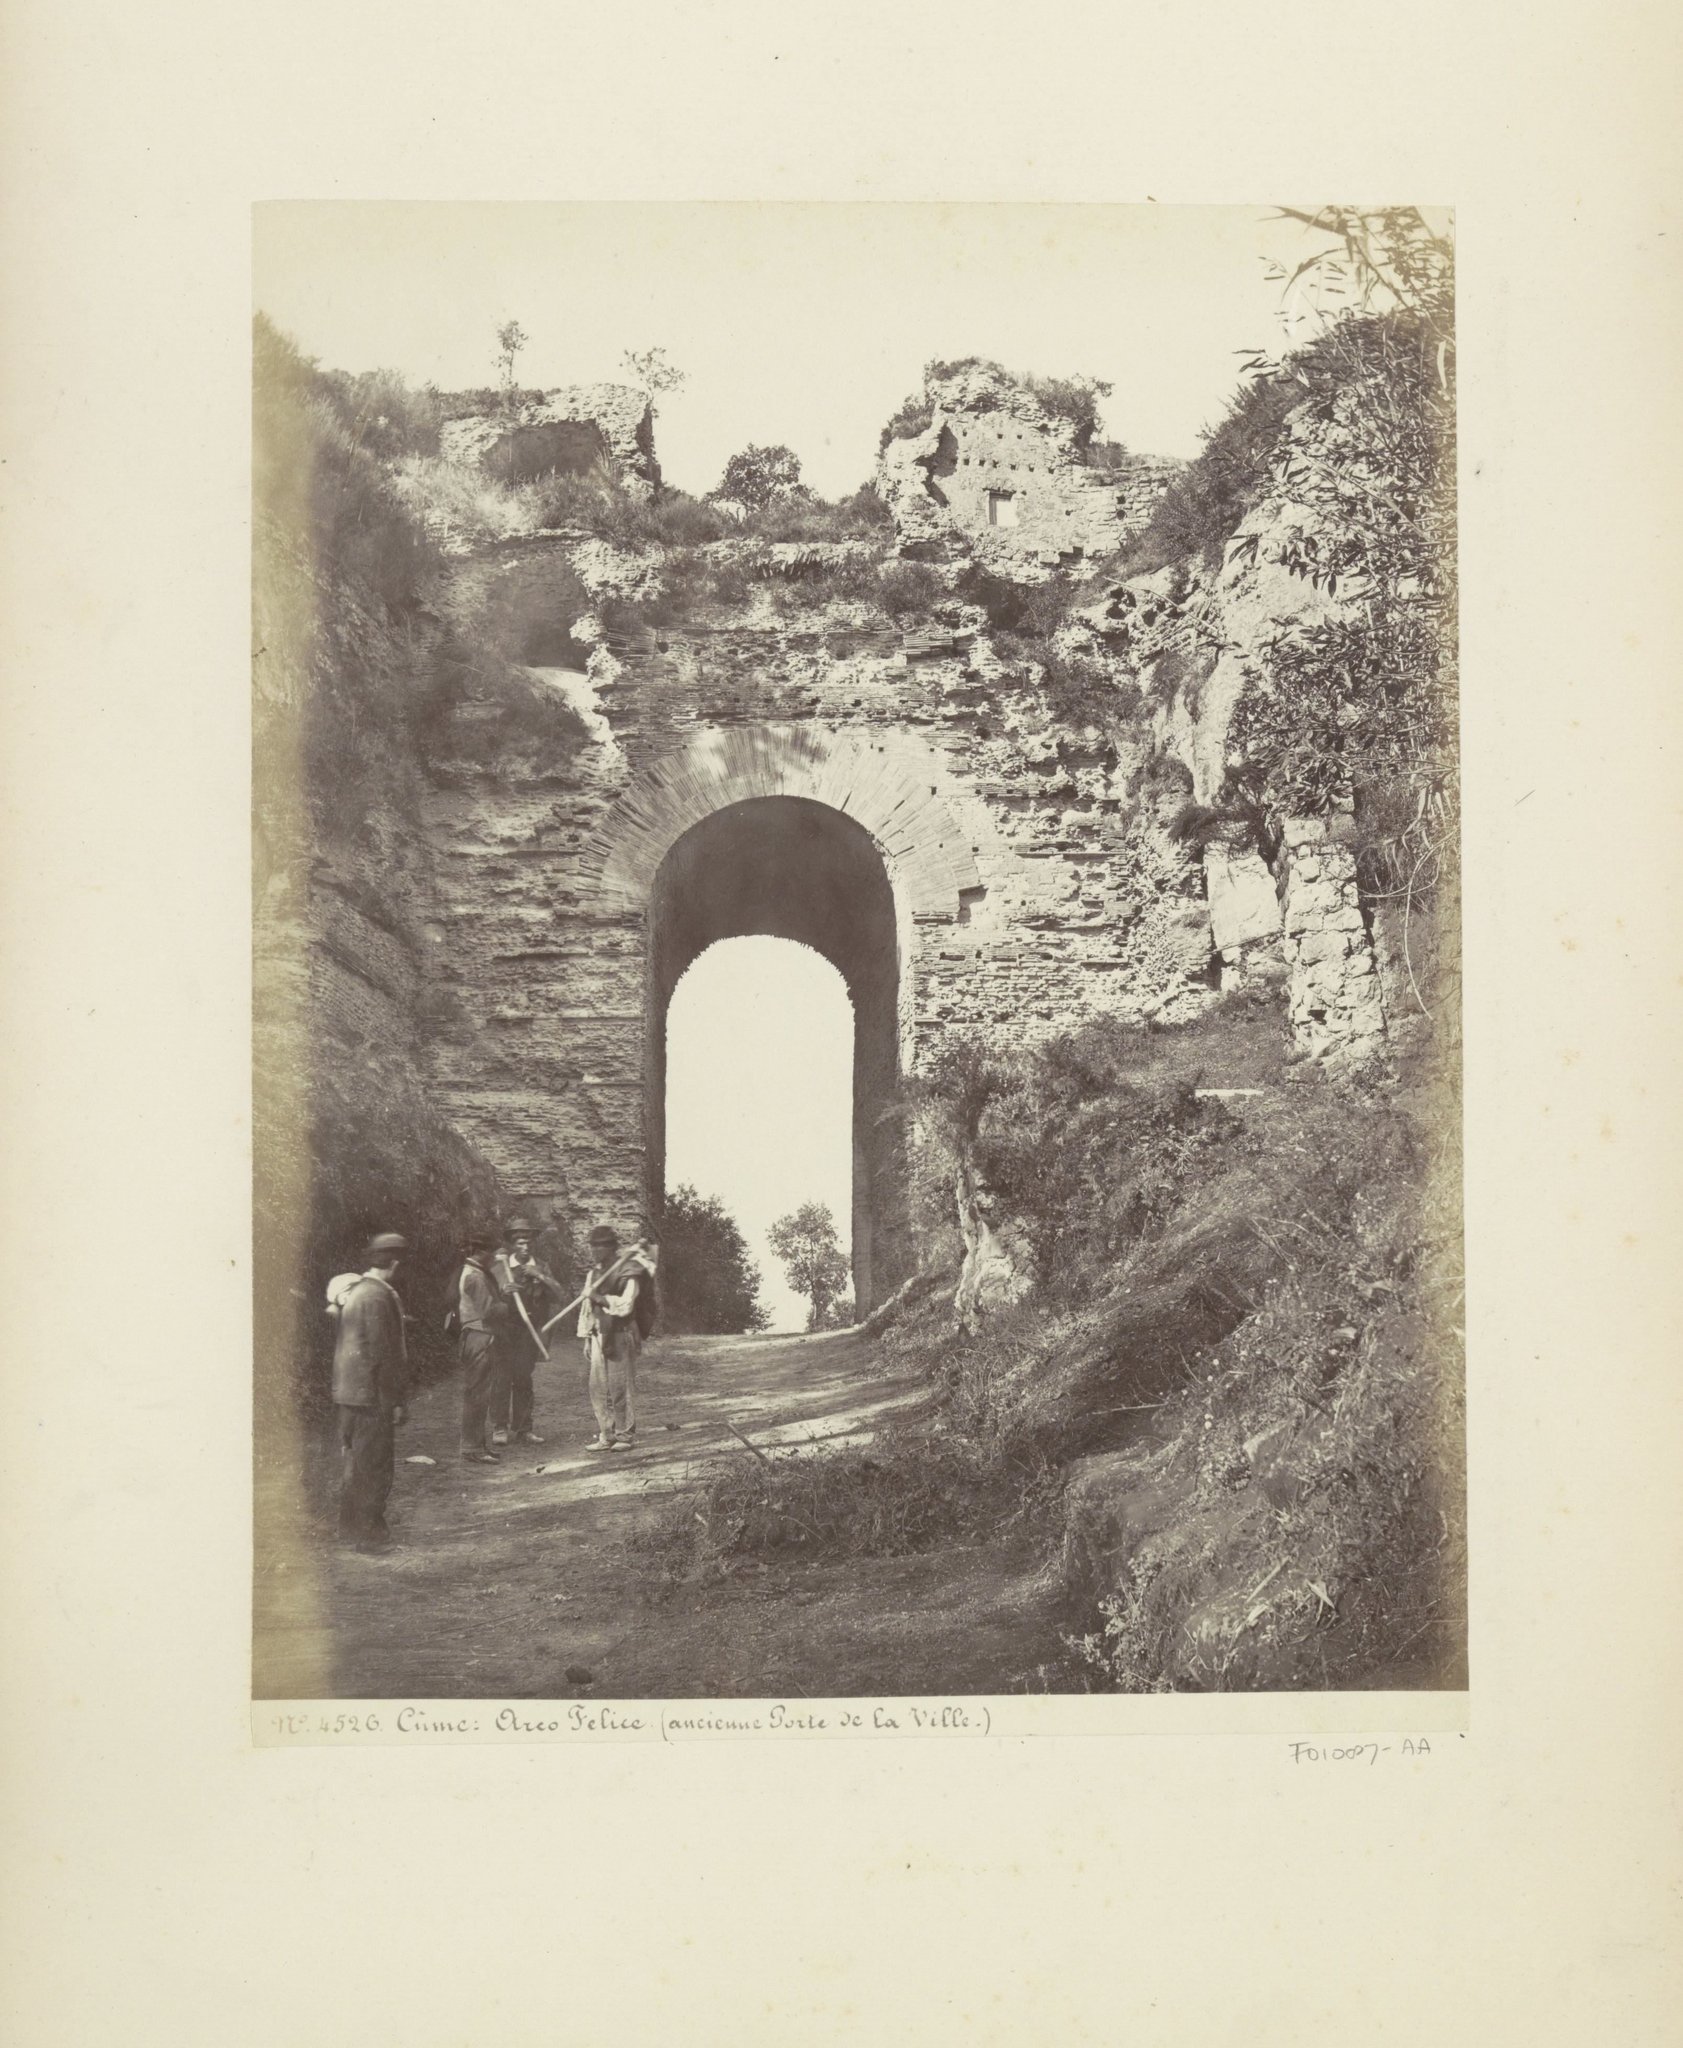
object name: photograph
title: Vier donkere mannen bij de Arco Felice tussen Pozzuoli en Cumae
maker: Anonymous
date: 1865-1875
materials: paper, photographic support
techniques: albumen print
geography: italy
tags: africans, gate, entrance, ruin of a dwelling, house, castle, etc., italy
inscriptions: negative number: ‘4526’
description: Onderdeel van Reisalbum met foto's van bezienswaardigheden in Napels en omgeving.